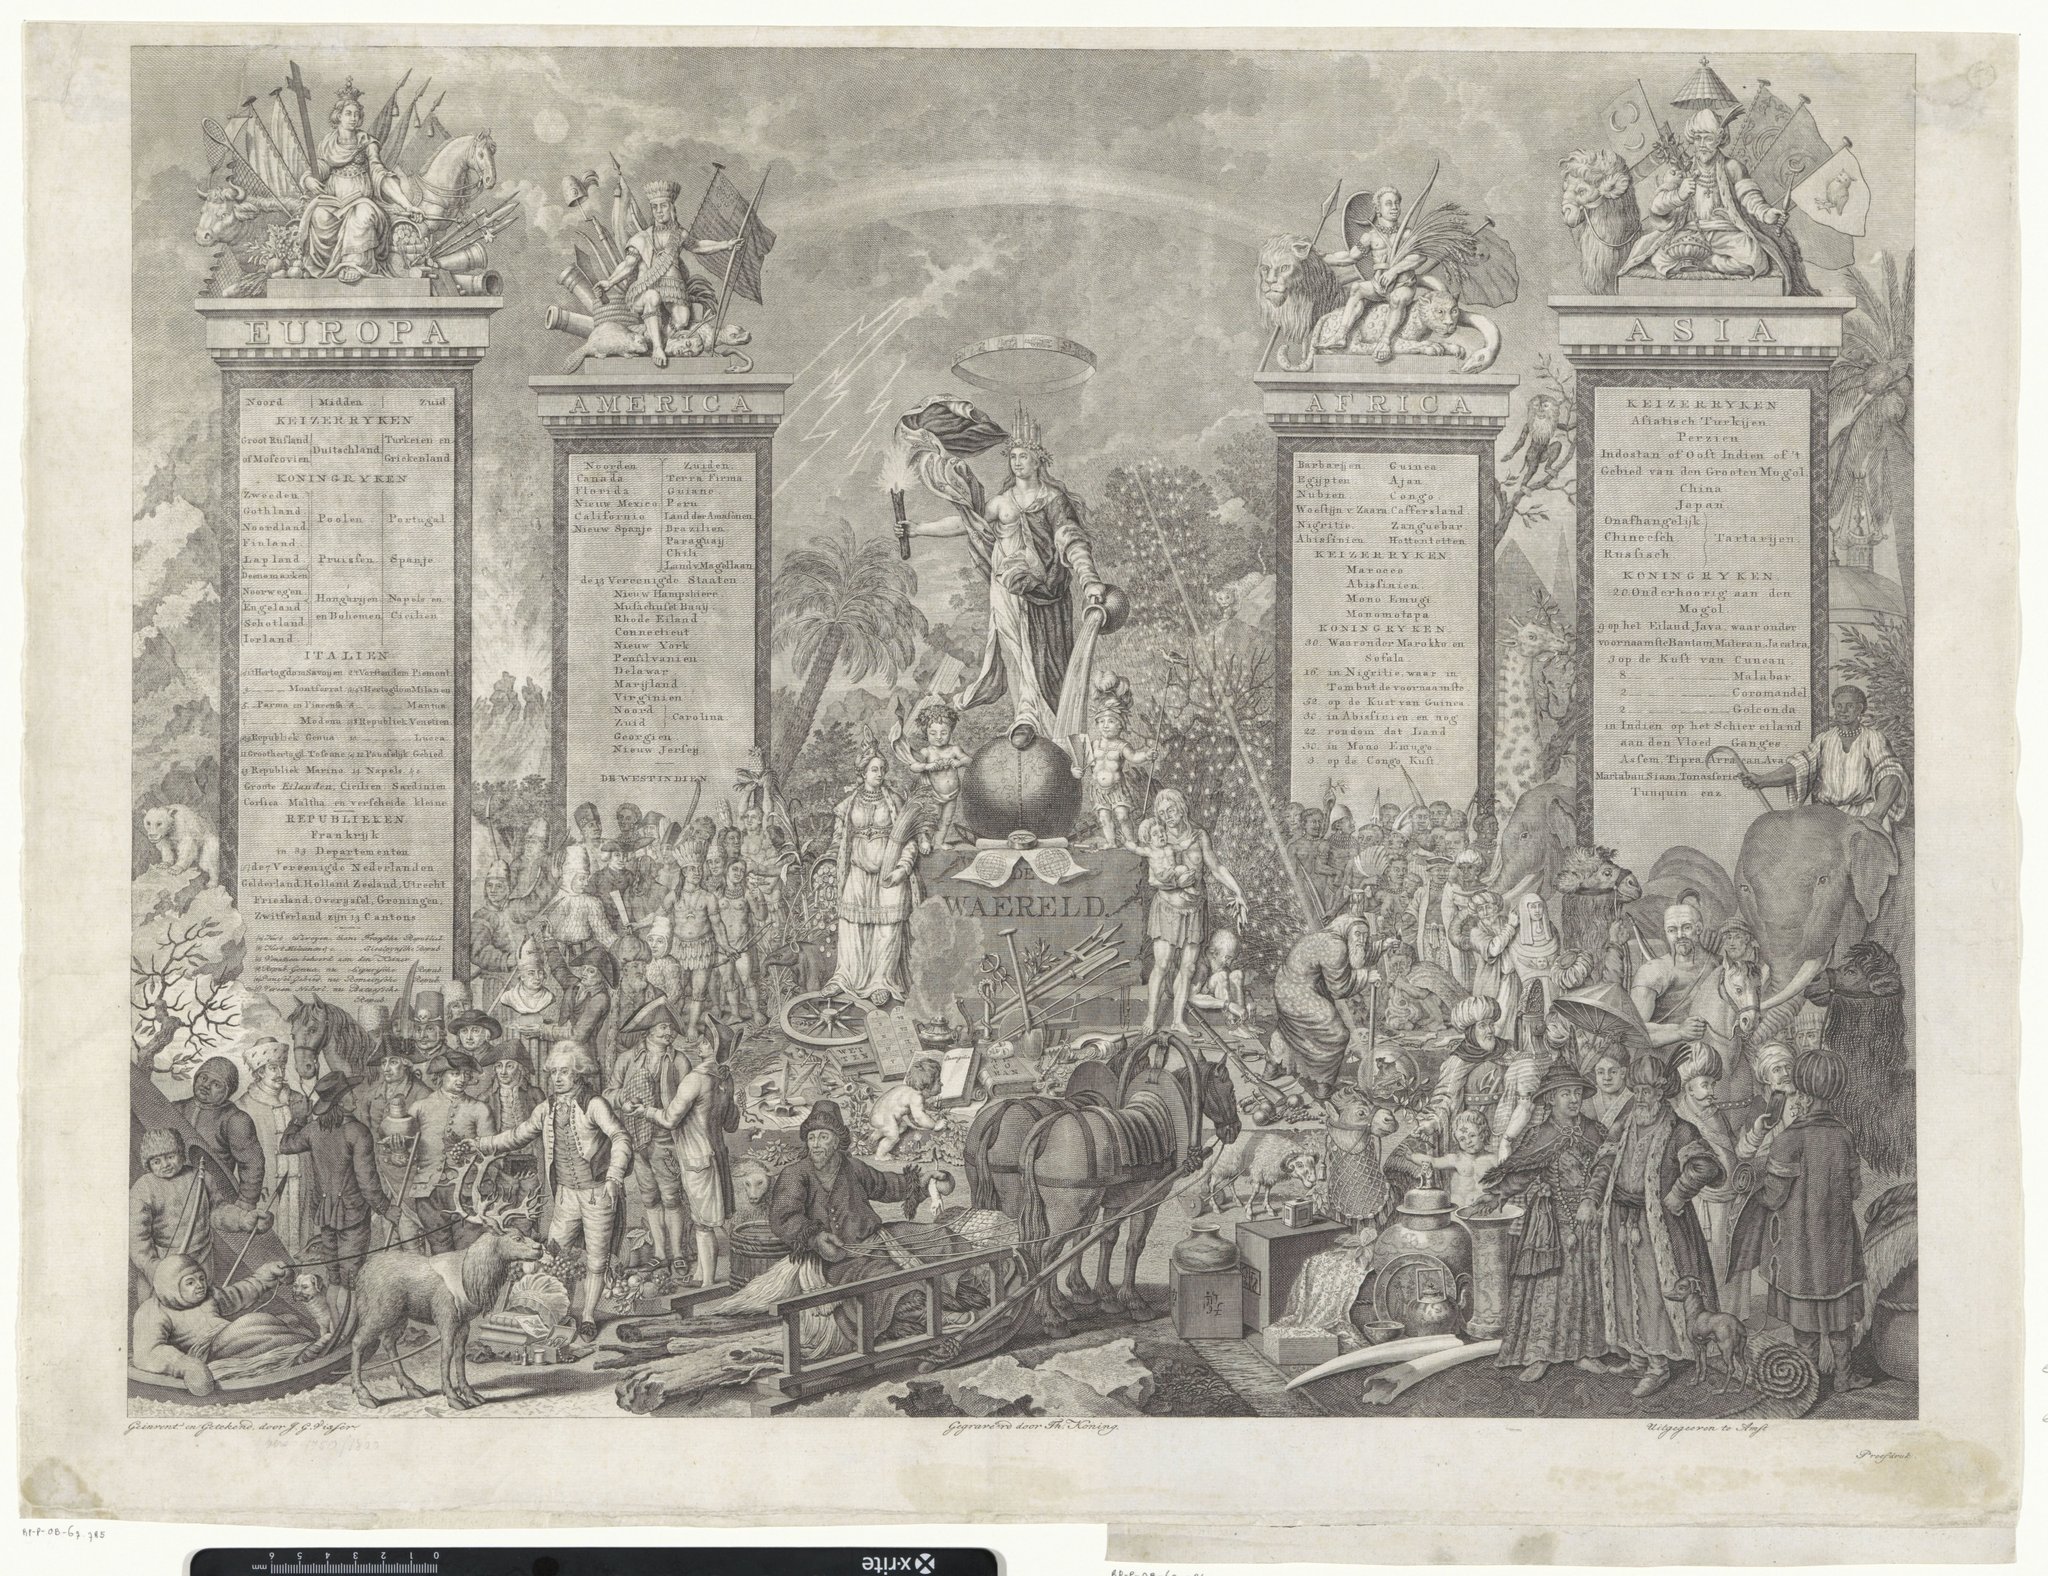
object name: print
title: Allegorische voorstelling van de wereld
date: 1798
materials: paper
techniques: engraving, etching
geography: netherlands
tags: europe represented allegorically; 'europa' (ripa), asia represented allegorically; 'asia' (ripa), africa represented allegorically; 'africa' (ripa), america represented allegorically; 'america' (ripa)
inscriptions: collector's mark: Lugt 2228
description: Allegorische voorstelling van de wereld, met vier zuilen die vier werelddelen vertegenwoordigen (Europa, Amerika, Afrika en Azië). Voor de zuilen staan figuren en elementen die met de werelddelen geassocieerd kunnen worden. In het midden een piëdestal met een wereldbol waarop een personificatie van de wereld staat. Zij heeft in de hand een waterkruik en een fakkel, en draagt op het hoofd de stedenkroon. Boven haar hoofd de dierenriem met sterrenbeelden.